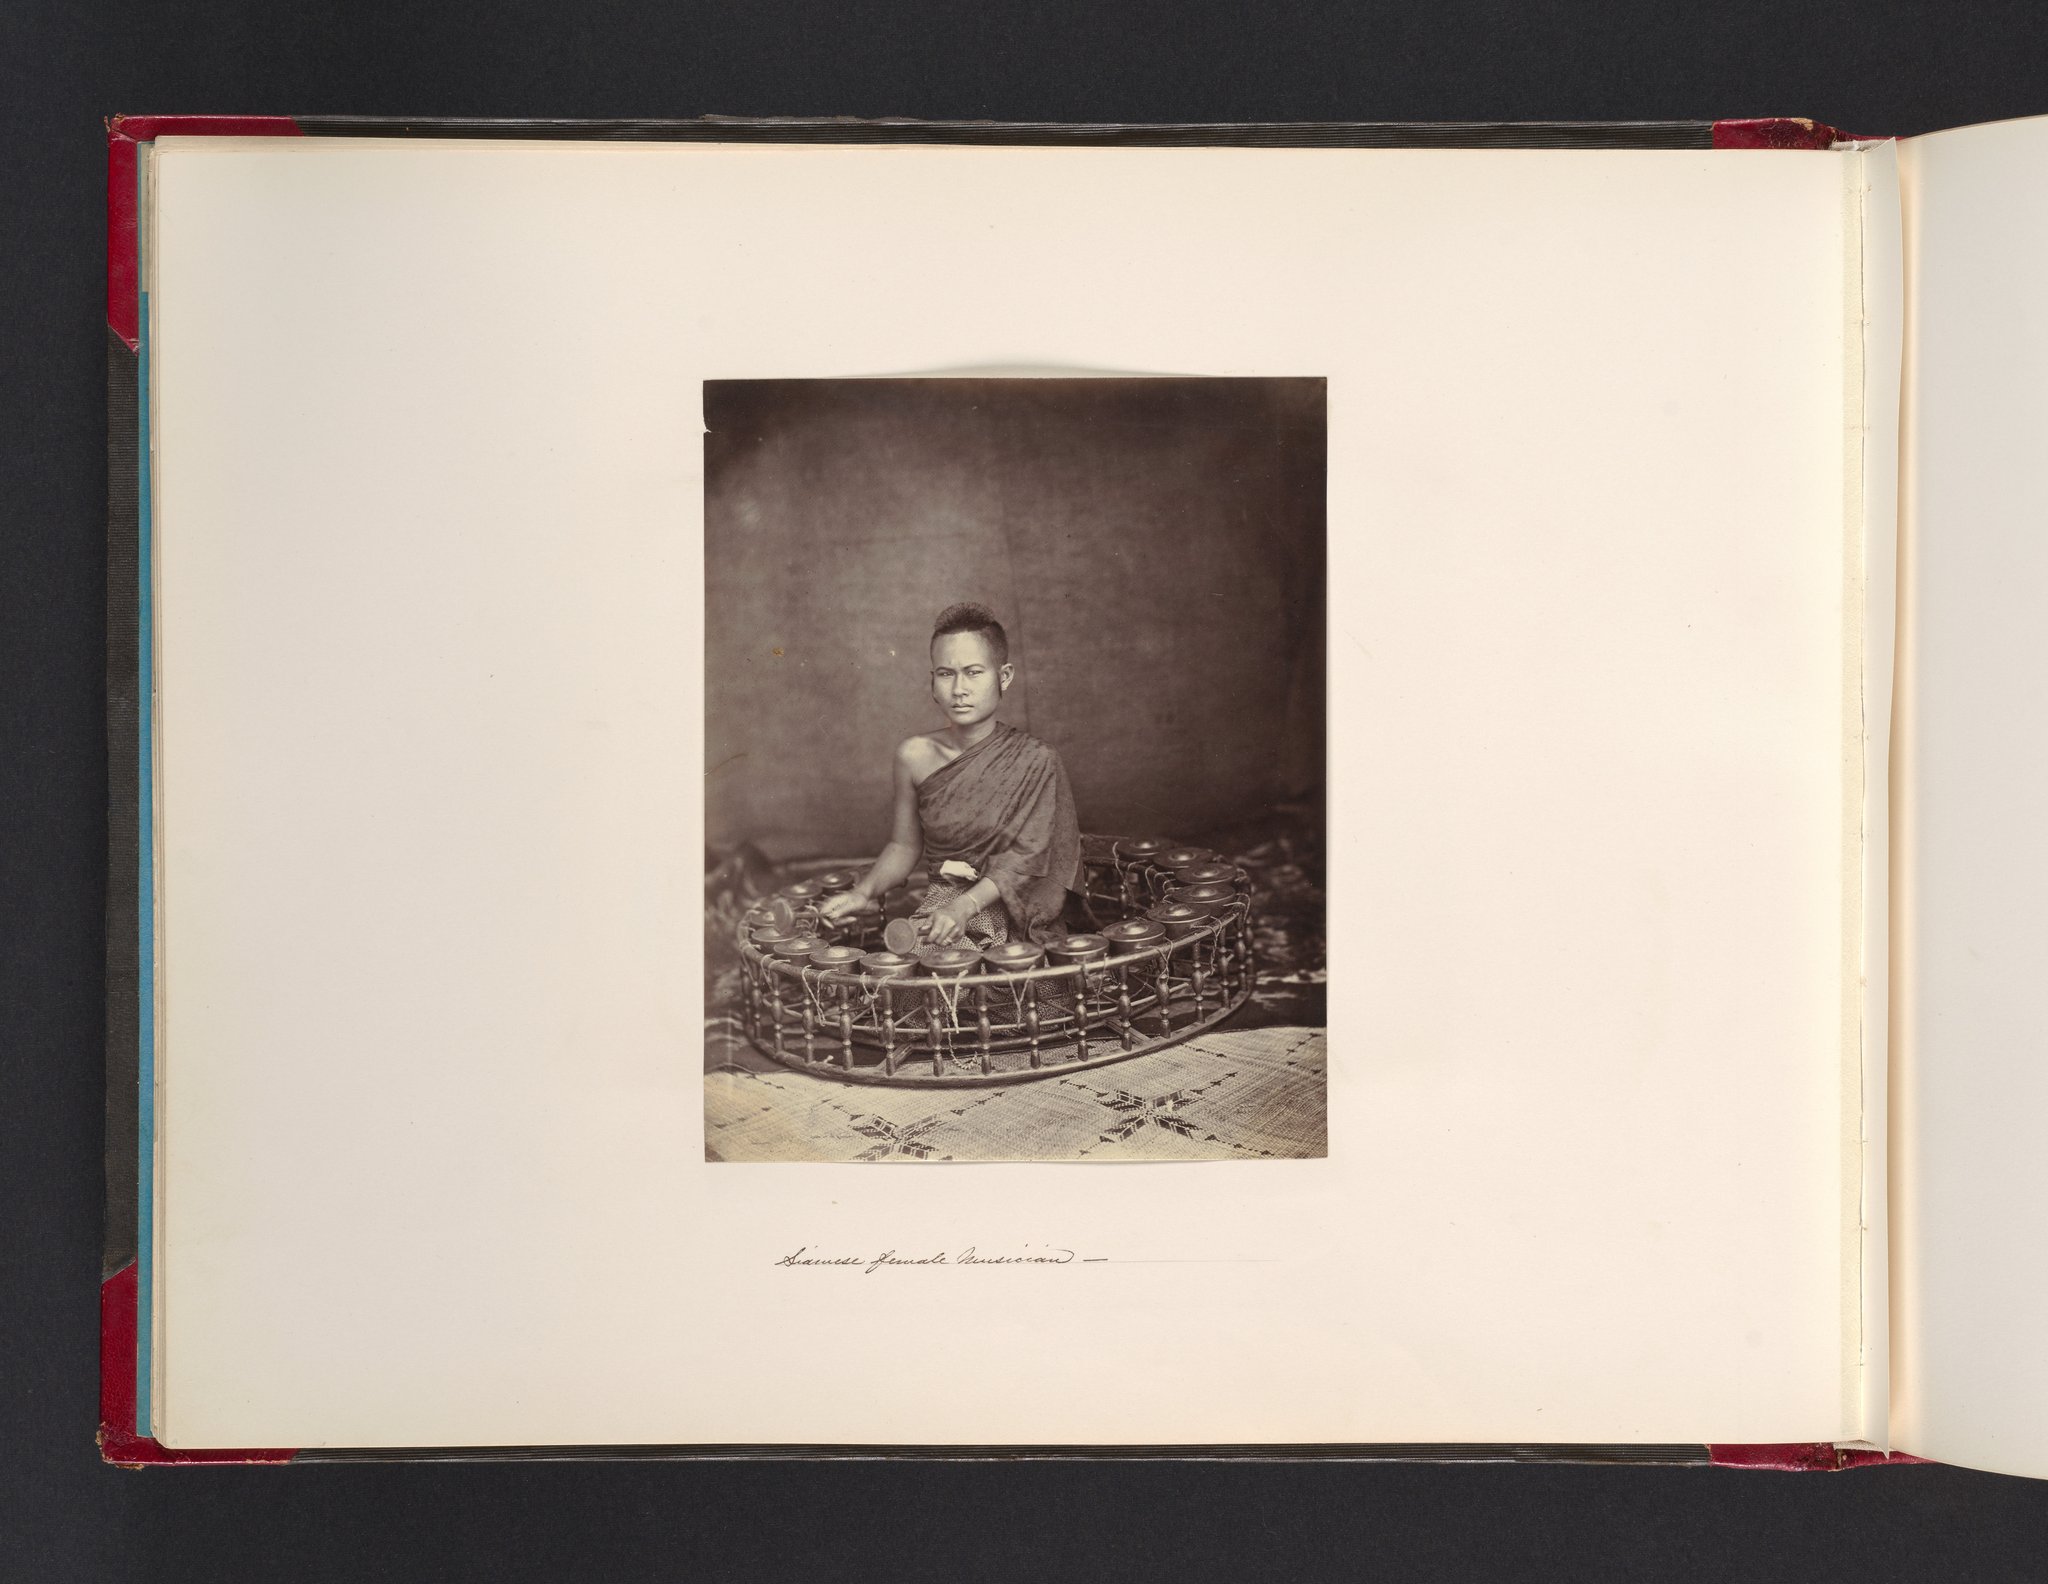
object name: photograph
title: Siames Female Musician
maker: john thomson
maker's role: artist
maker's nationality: british, scottish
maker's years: 1837-1921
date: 1865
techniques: albumen silver print, glass negative